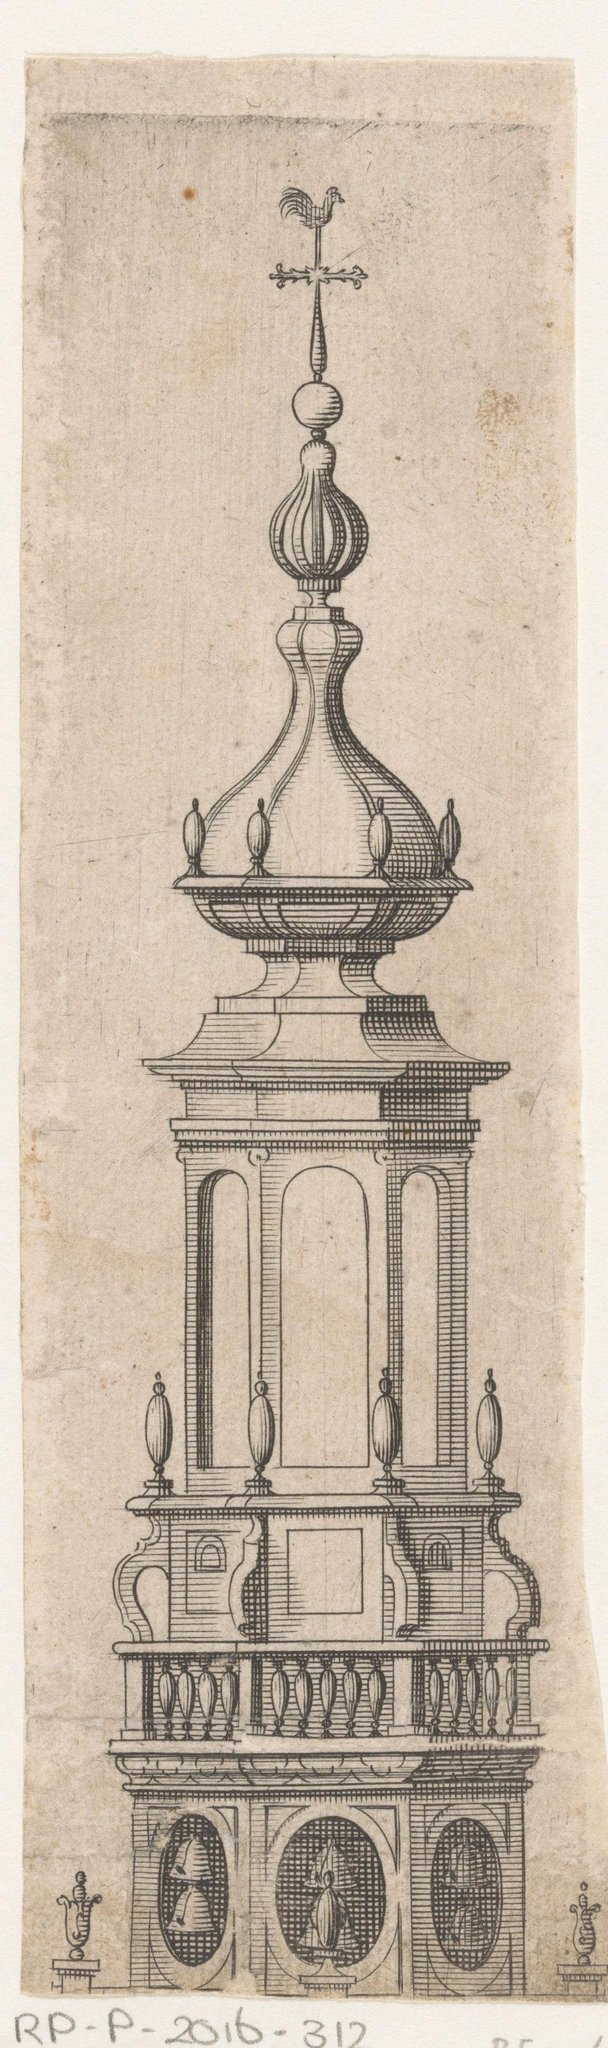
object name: print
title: Pinakel van de Zuiderkerk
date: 1631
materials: paper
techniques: engraving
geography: amsterdam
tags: exterior ~ architectural design or model, parts of church exterior and annexes: tower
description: Prent uit: Keyser, Hendrick de. Architectura moderna ofte bouwinge van onsen tyt (...) alle gedaen by (...) Amsterdam: Danckerts, Cornelis, 1631.